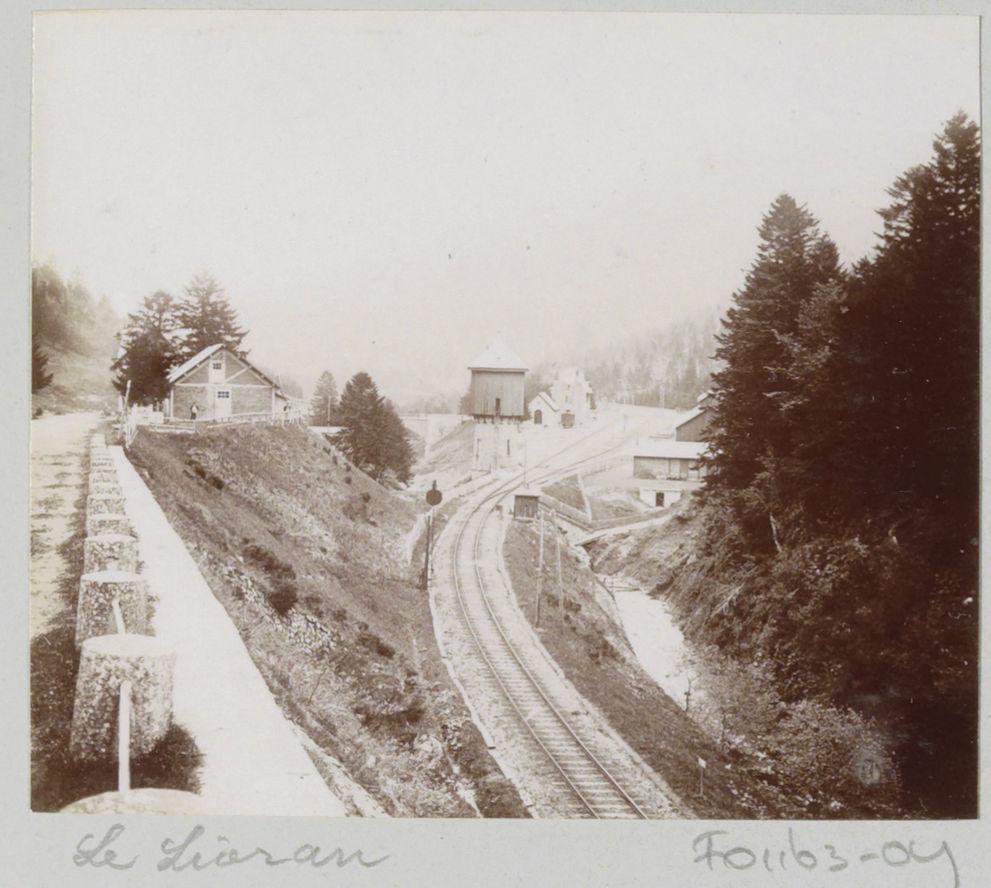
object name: photograph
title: Gezicht op een spoorweg met station en watertoren in Le Lioran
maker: delizy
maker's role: manufacturer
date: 1902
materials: paper, photographic support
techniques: gelatin silver print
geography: le lioran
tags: water tower, railway, train, station; shelter (railway, tramway)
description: Onderdeel van Fotoalbum van een Franse amateurfotograaf met opnames van uitstapjes in Frankrijk, Spanje, België, Luxemburg en Nederland, de eerste automobielen en autoraces.